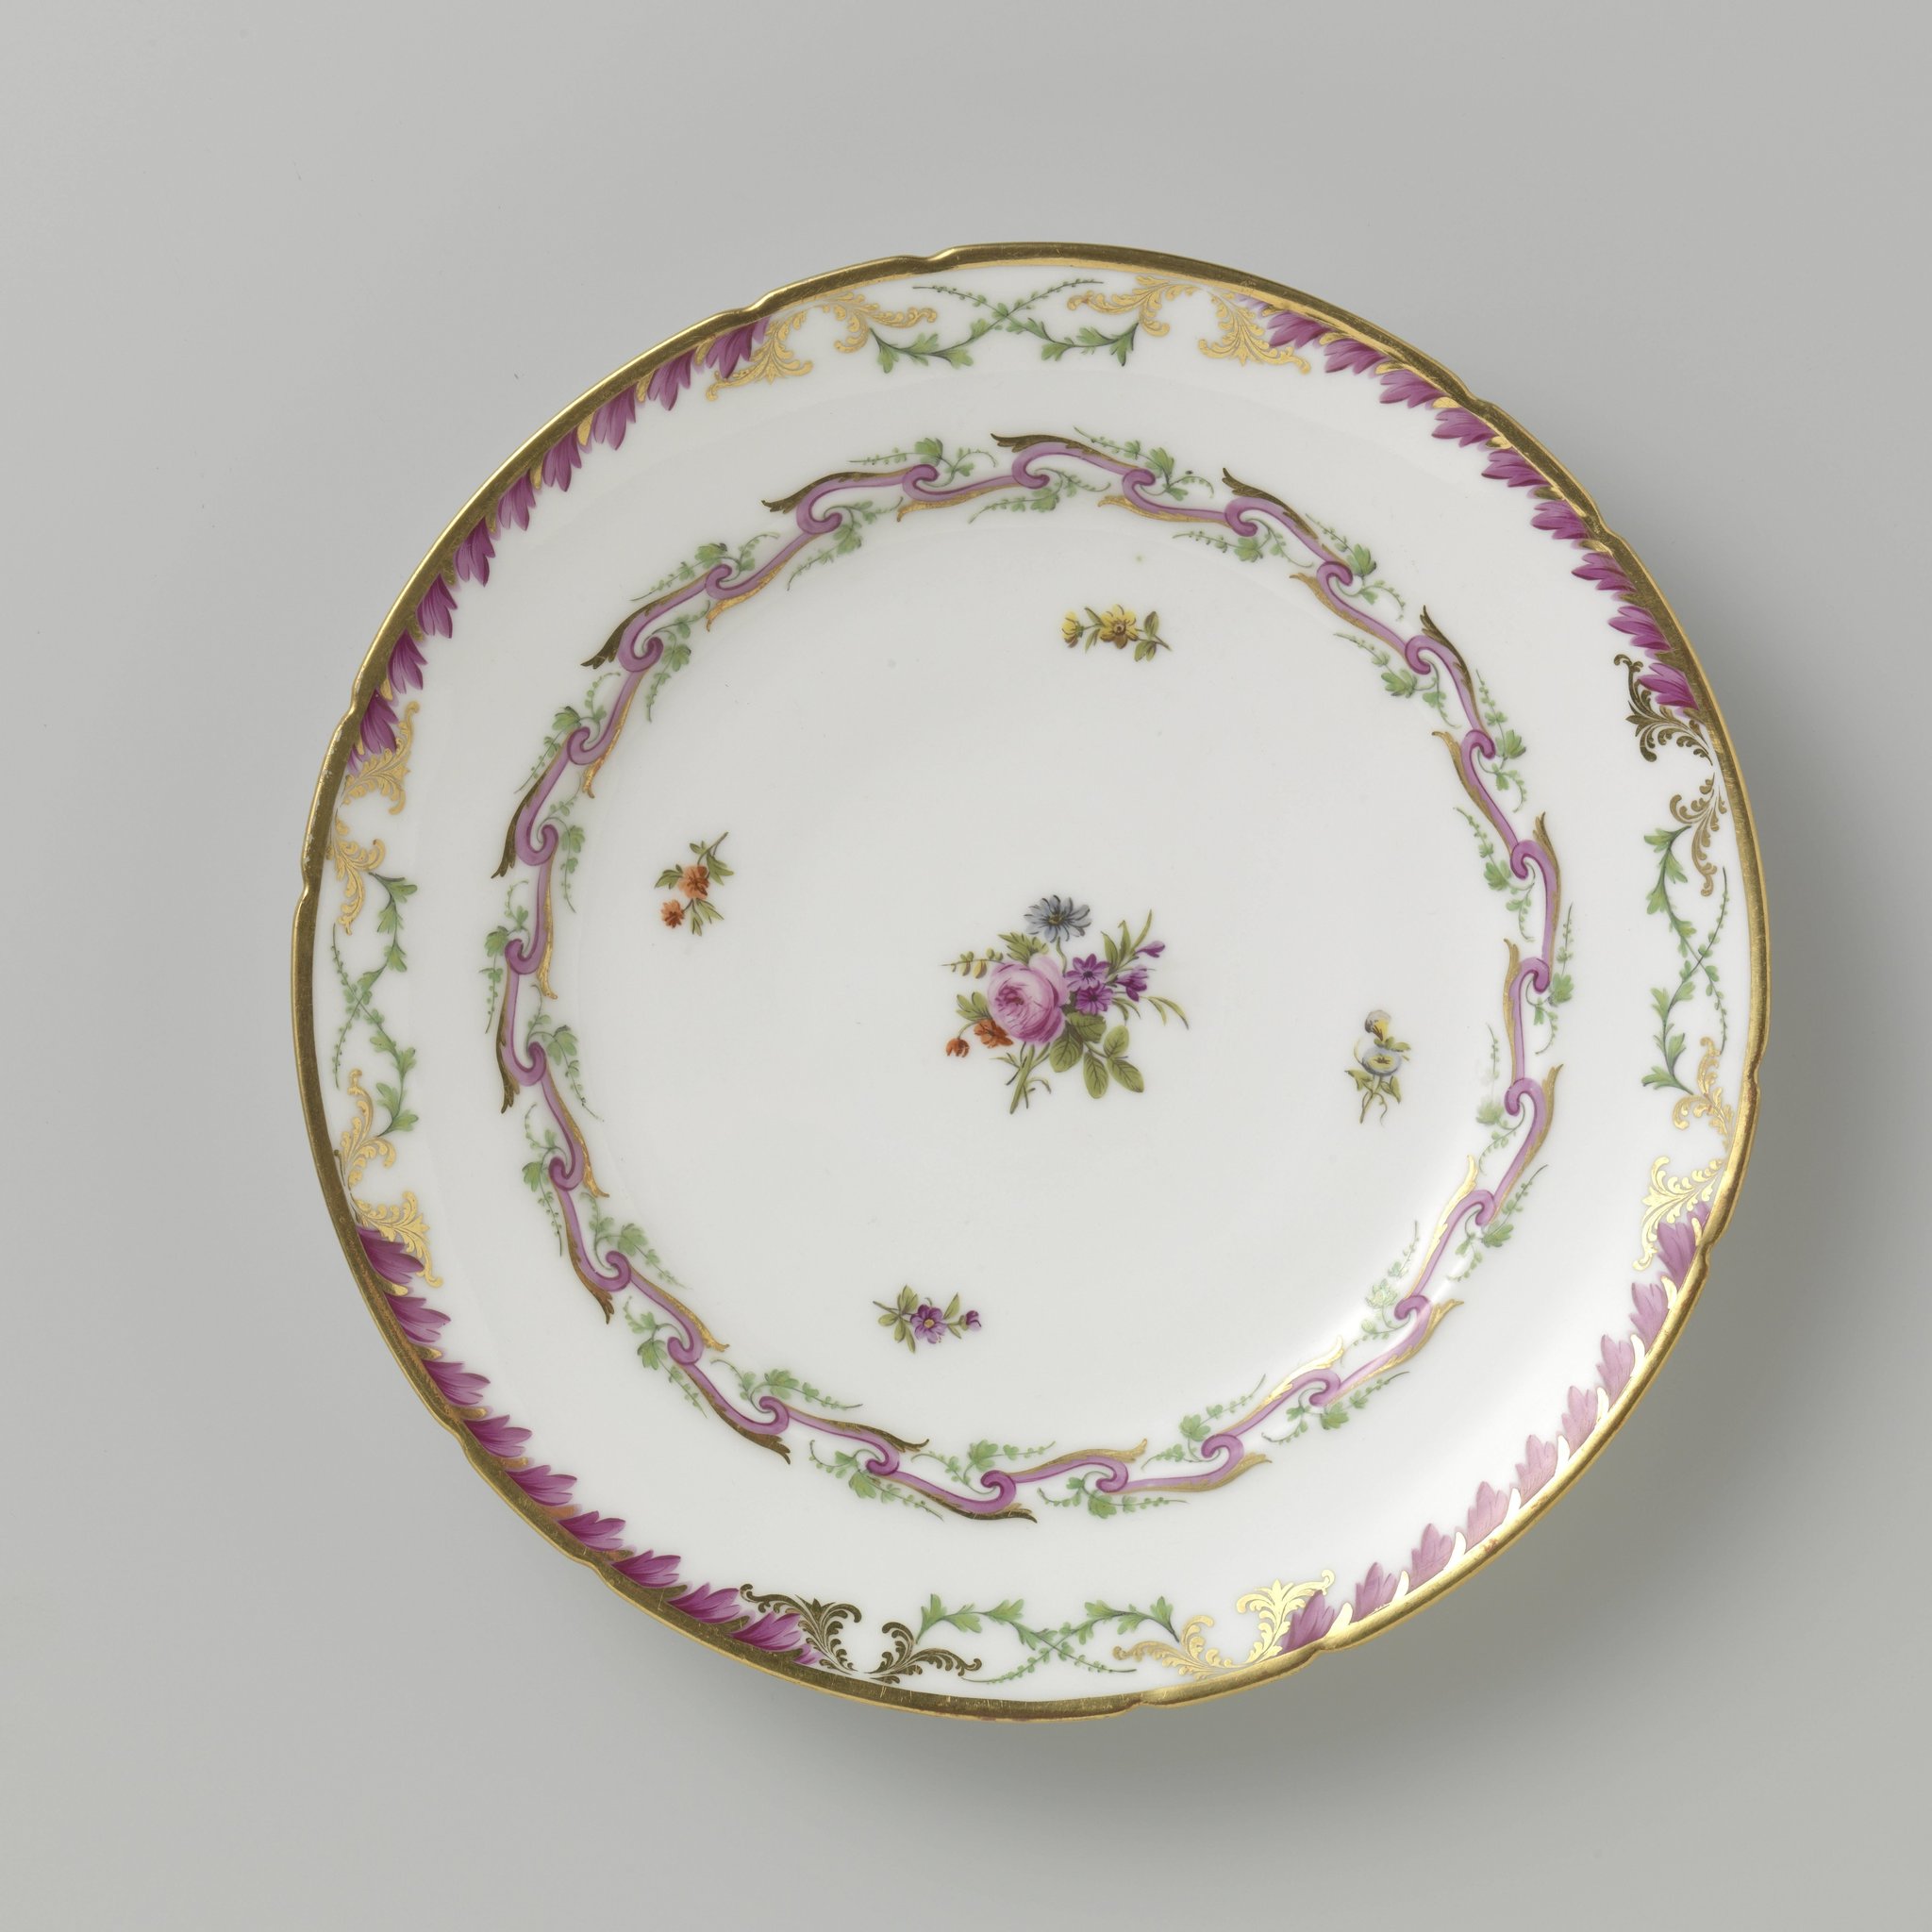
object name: plate dish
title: Bord, plat model, behorend bij een servies met geslingerd lintmotief met bladertakken, bloemboeketten en gestrooide bloemtakken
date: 1780-1820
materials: porcelain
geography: amsterdam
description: Bord, plat model, behorend bij een servies van porselein met geslingerd lintmotief in paars en goud met groene bladertakken, bloemboeketten en gestrooide bloemtakken. Randen lichtgegolfd met decoratie in goud met paars bladmotief waartussen groen gekruist bladmotief. Gemerkt: M.O.L. of AMSTEL.